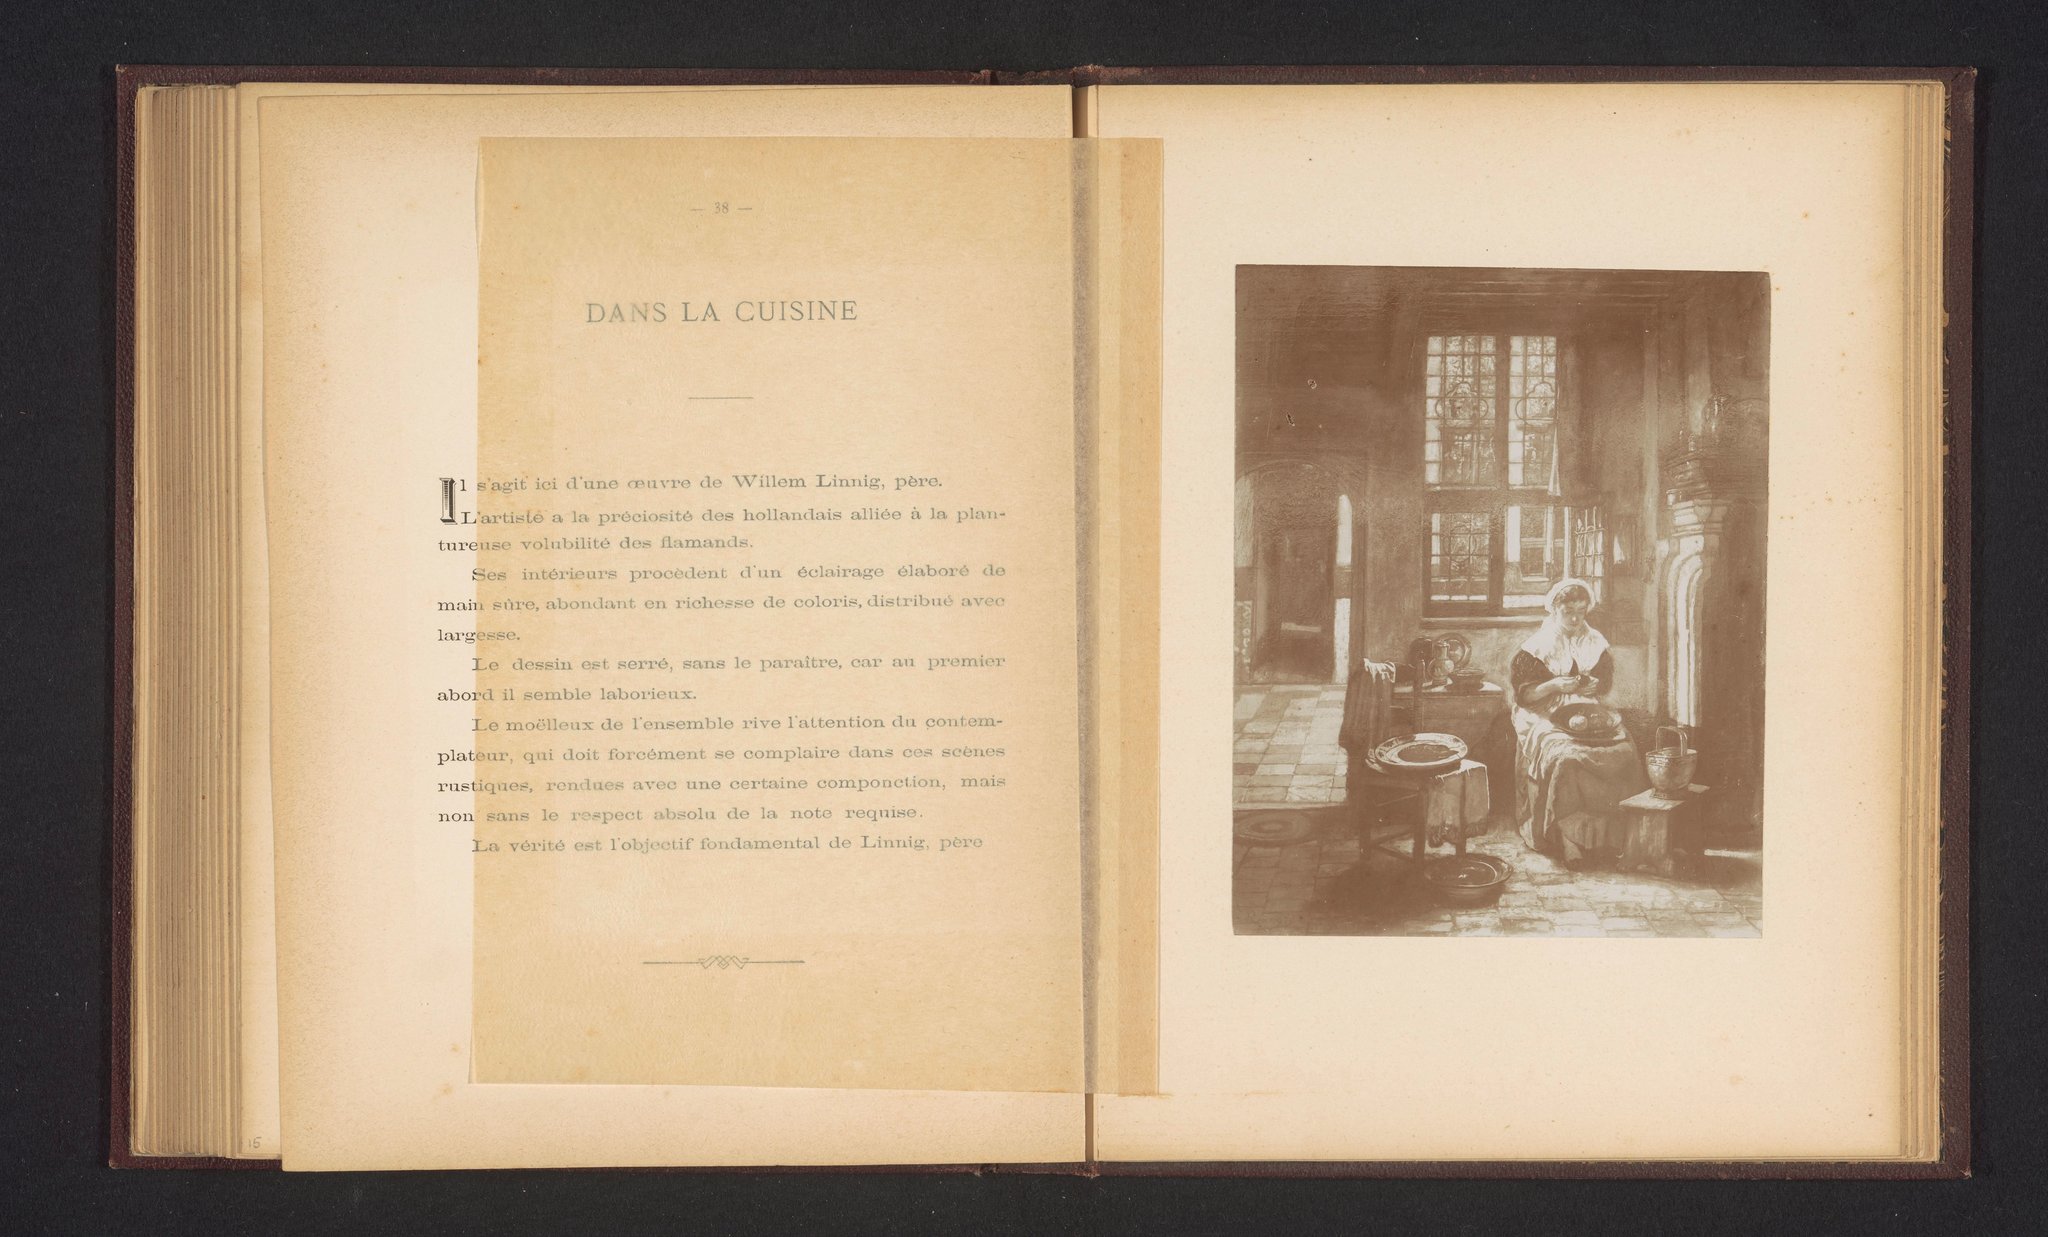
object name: photograph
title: Fotoreproductie van een schilderij van een vrouw die aardappels schilt in een keuken door Willem Linnig (II)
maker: alexandre van antro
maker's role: painter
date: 1891-1896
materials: photographic support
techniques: collodion silver print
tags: kitchen, adult woman, potatoes